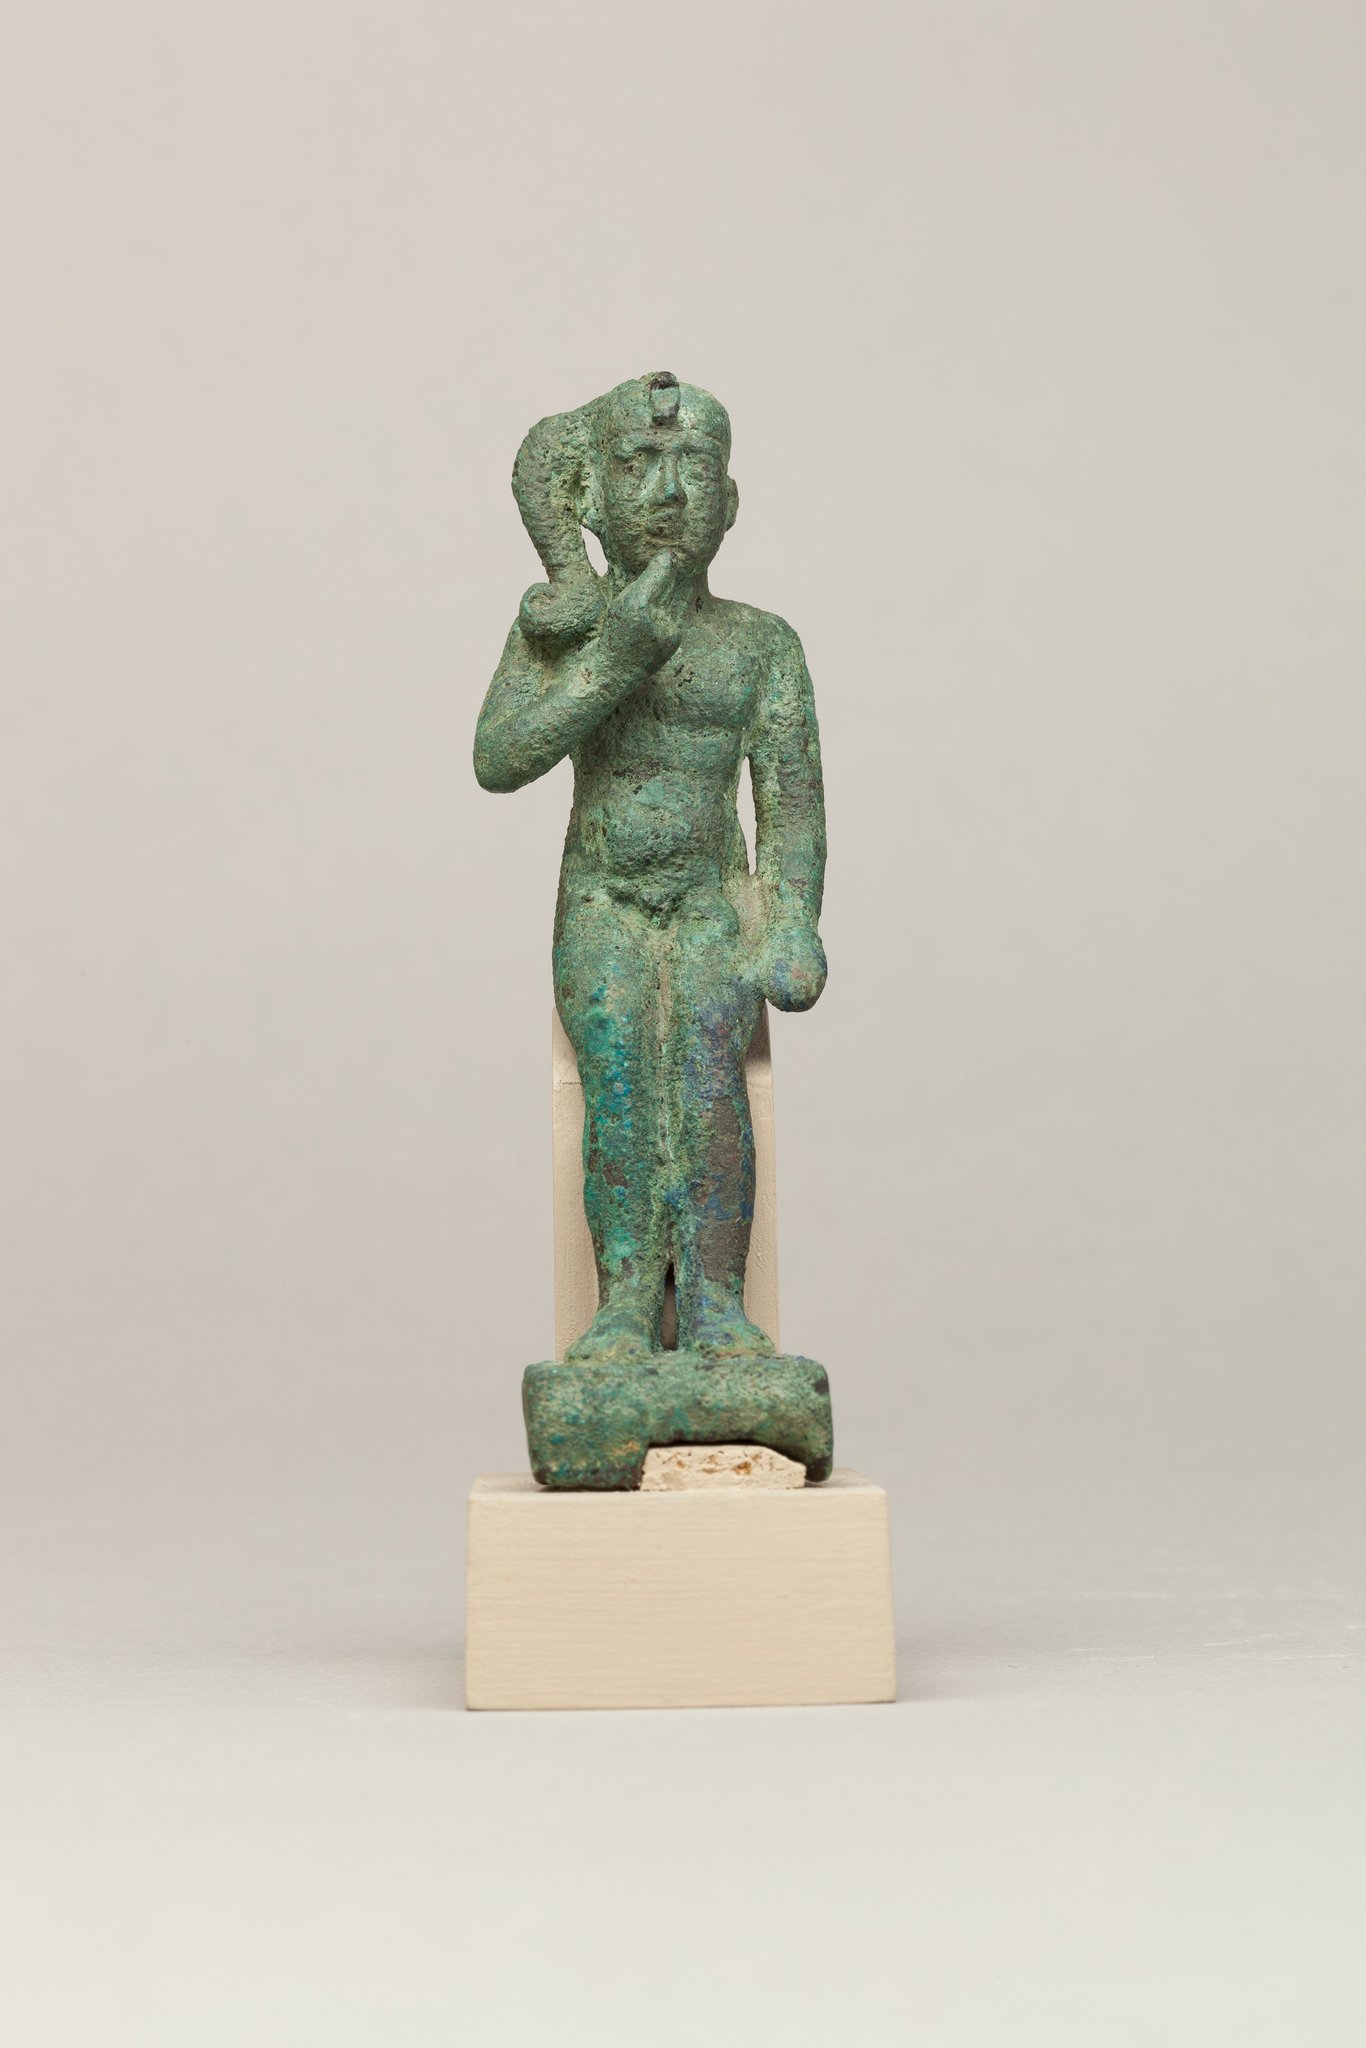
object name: statuette, child god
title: Child god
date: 664-630 BCE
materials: metal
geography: egypt